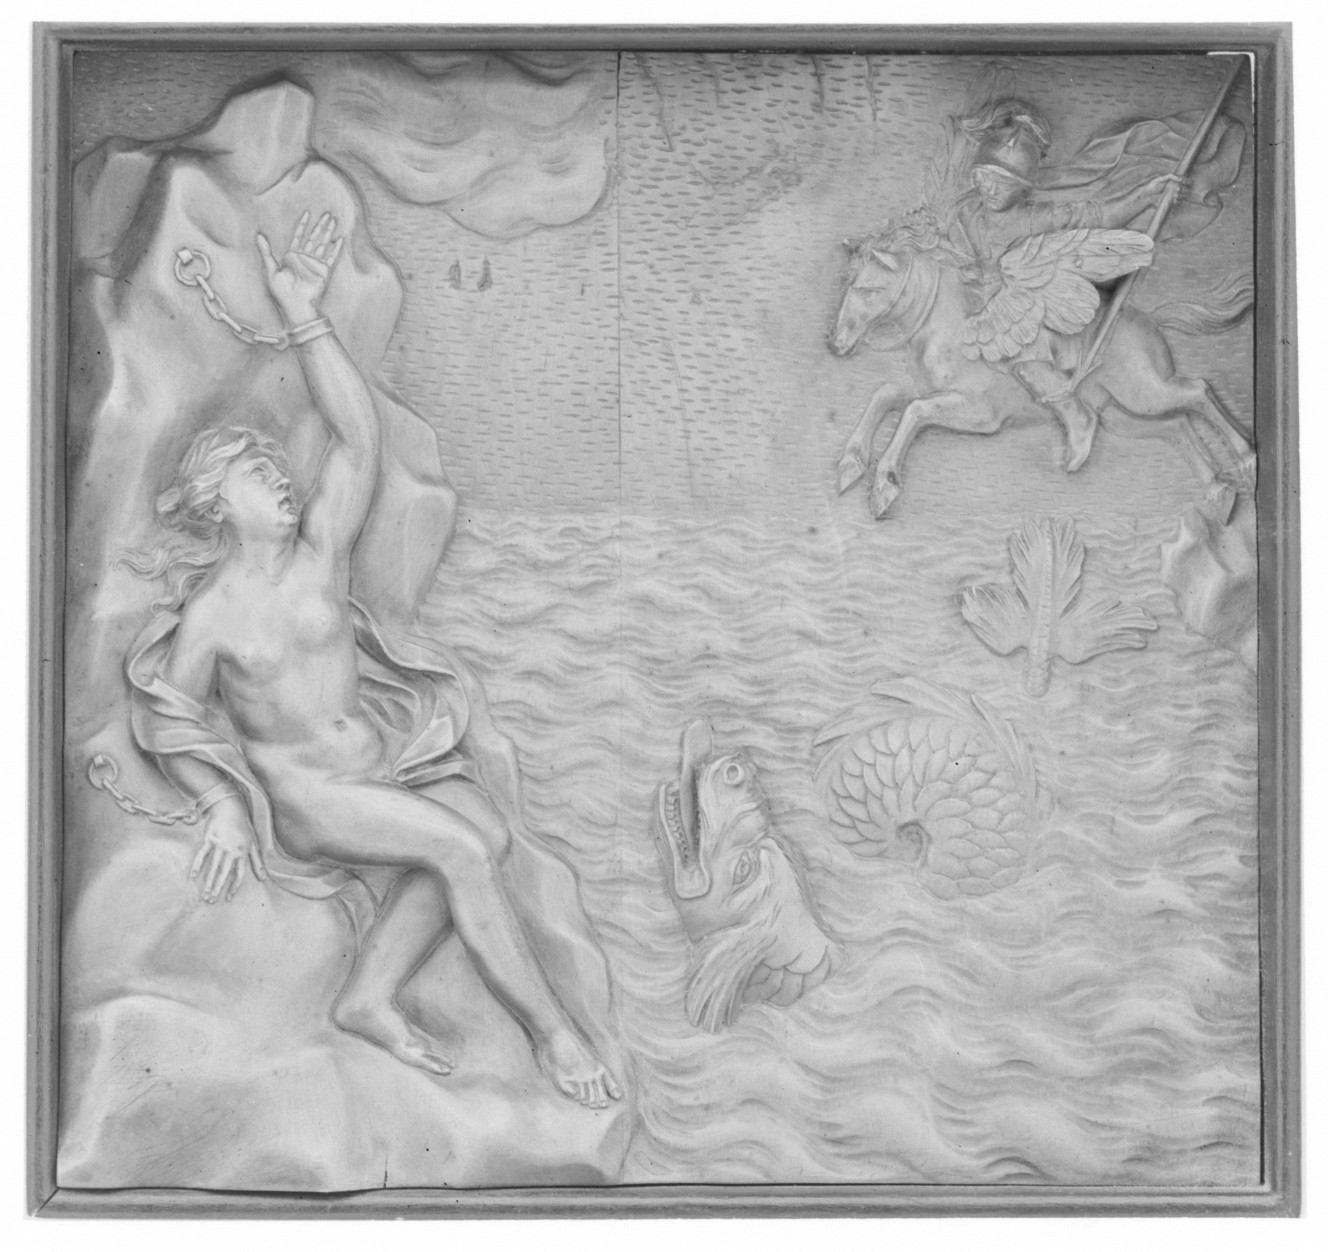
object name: relief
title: Perseus and Andromeda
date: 1600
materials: wood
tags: andromeda,perseus,pegasus